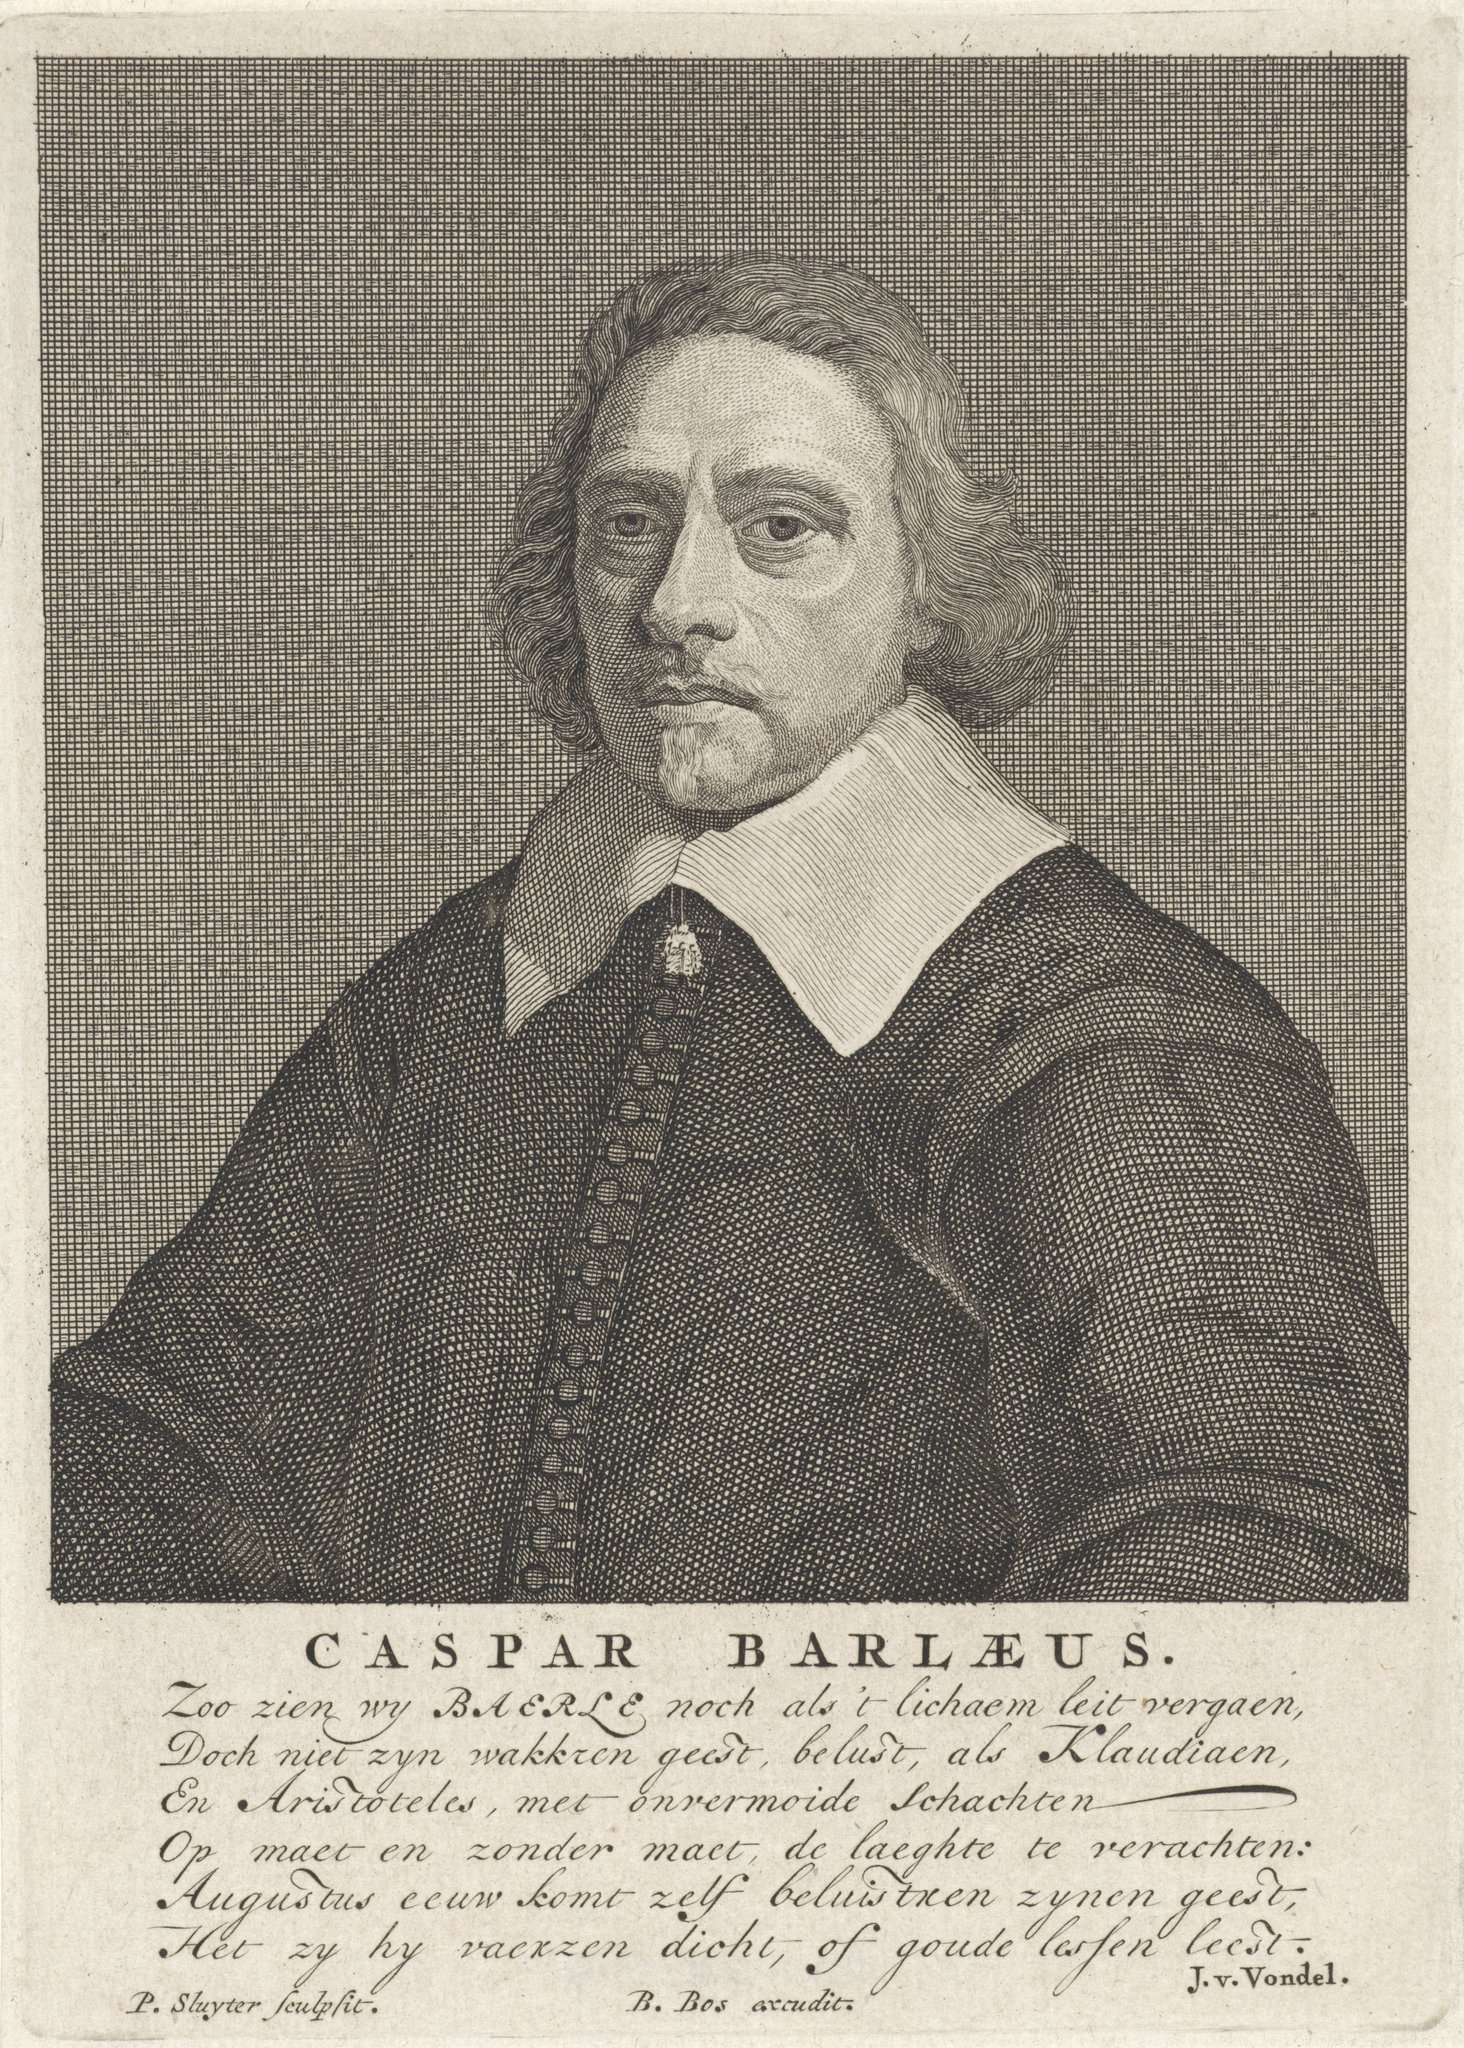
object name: print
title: Portret van Caspar van Baerle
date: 1704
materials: paper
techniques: etching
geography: amsterdam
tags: amsterdam, caspar van baerle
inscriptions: collector's mark: Lugt 2228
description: Prent ook gebruikt in: G. Brandts Historie der Reformatie, en andre kerkelyke geschiedenissen, in en ontrent de Nederlanden. Het vierde deel. Rotterdam: Barent Bos, 1704, tussen p. 954 en 955.